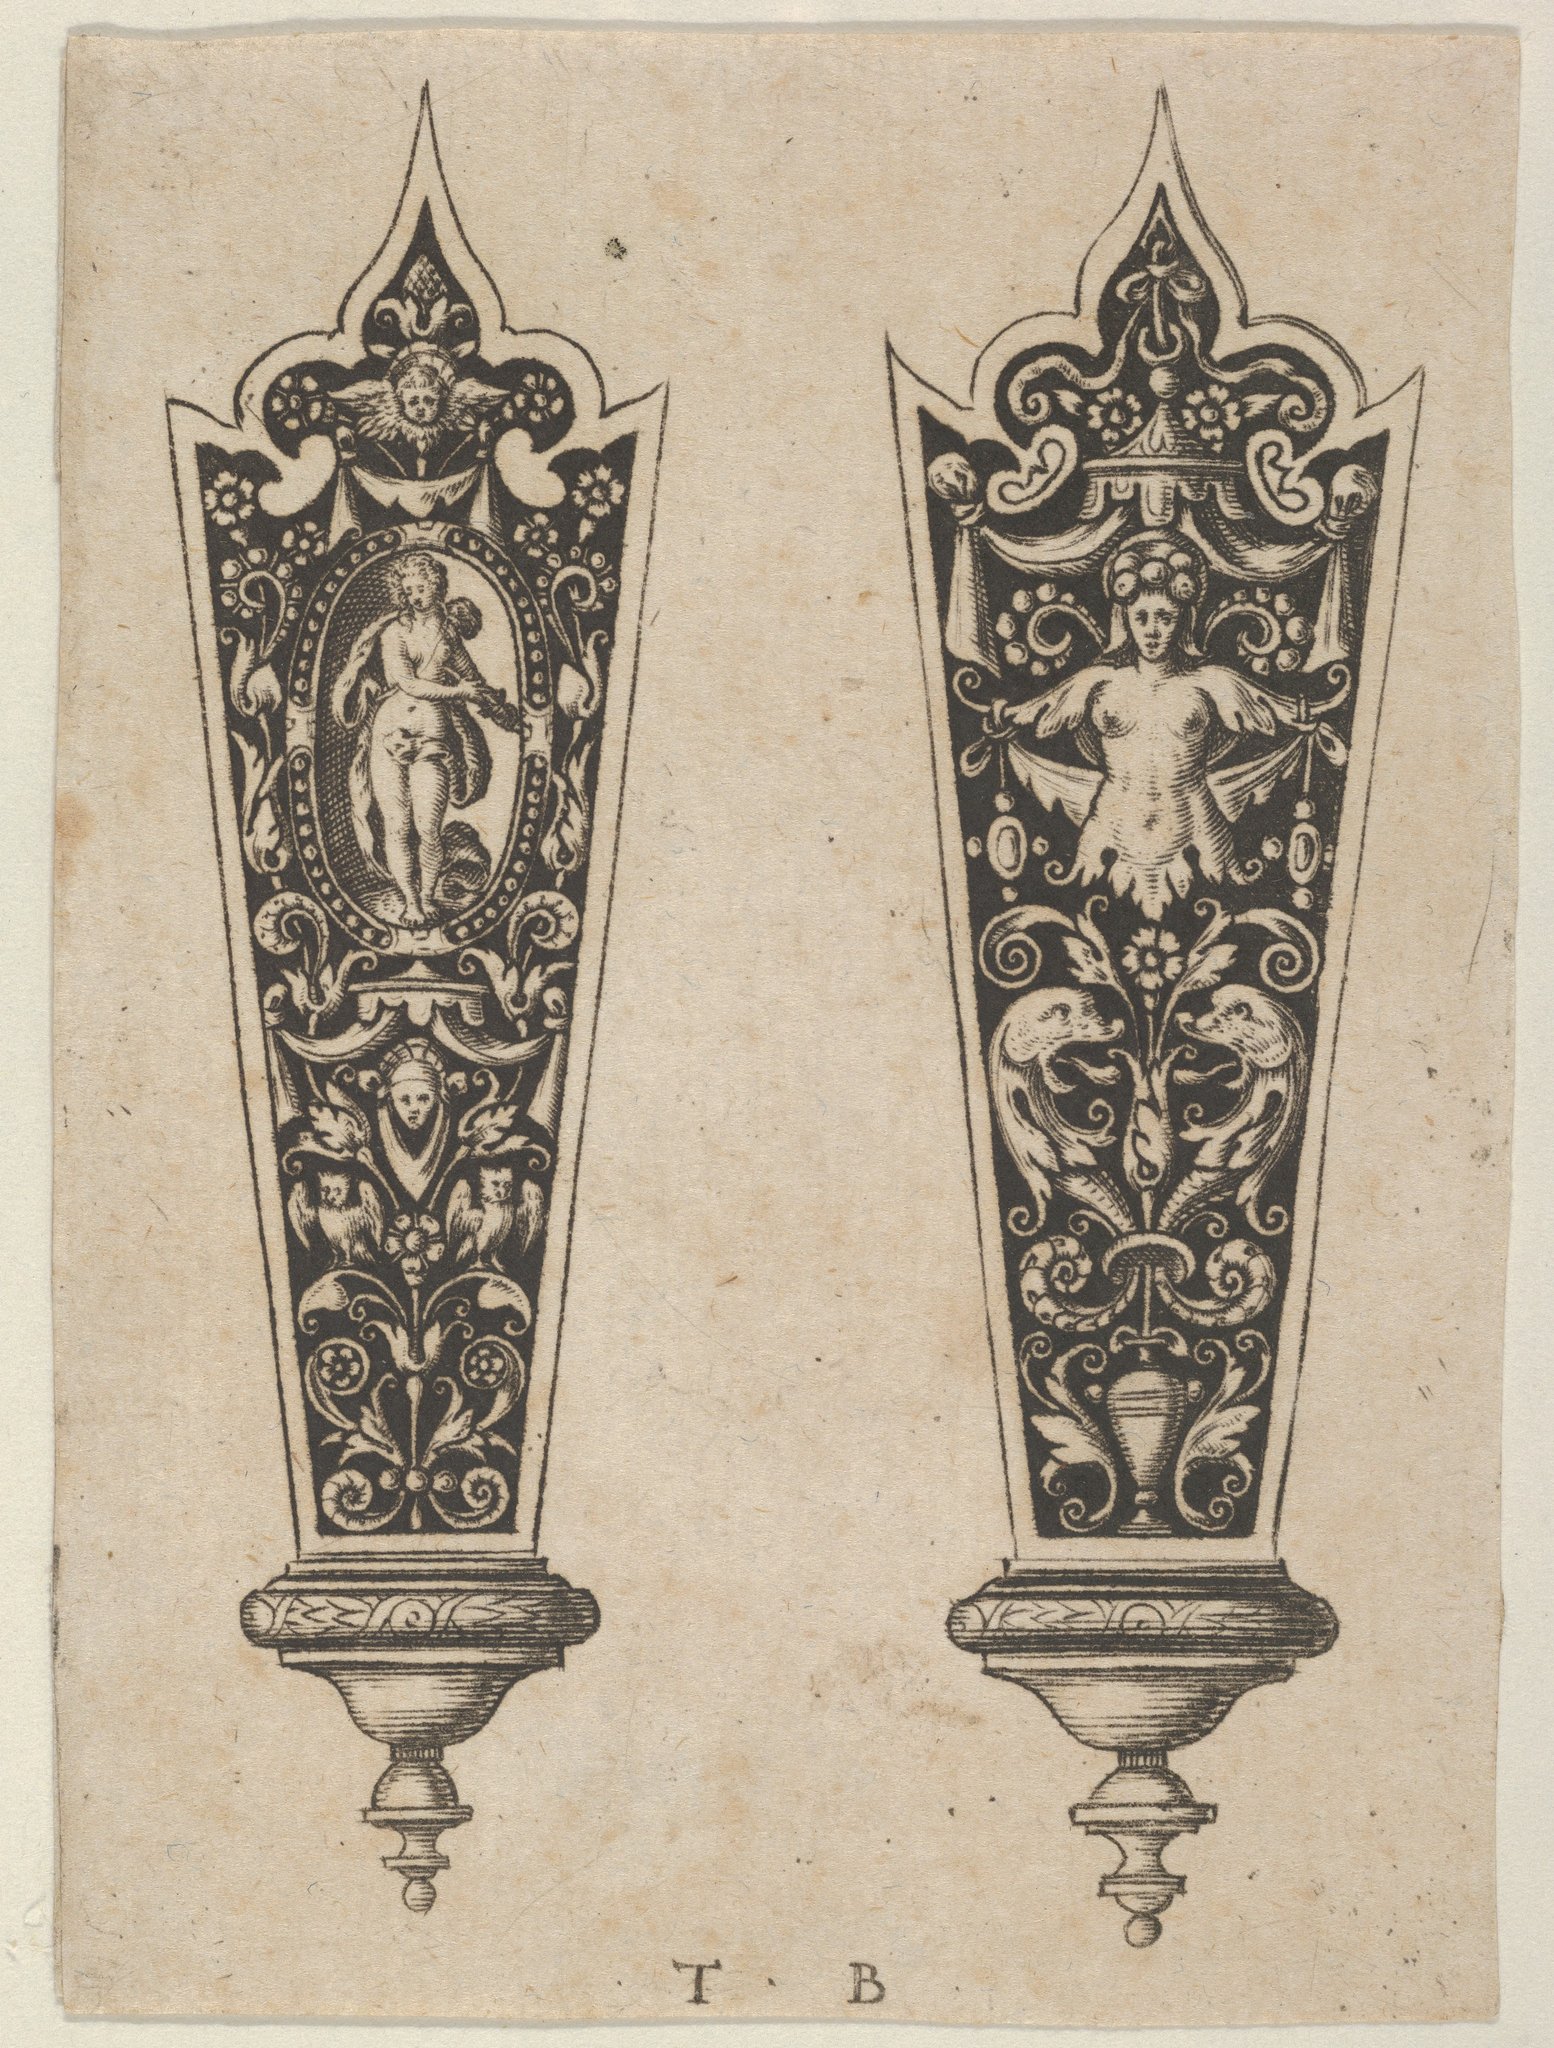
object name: print ornament architecture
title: Design for Knife Handles with the Death of Lucretia and Grotesques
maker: theodor de bry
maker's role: artist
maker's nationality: netherlandish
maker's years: 1528-1598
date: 1580-1600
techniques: embroidery, engraving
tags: hilts